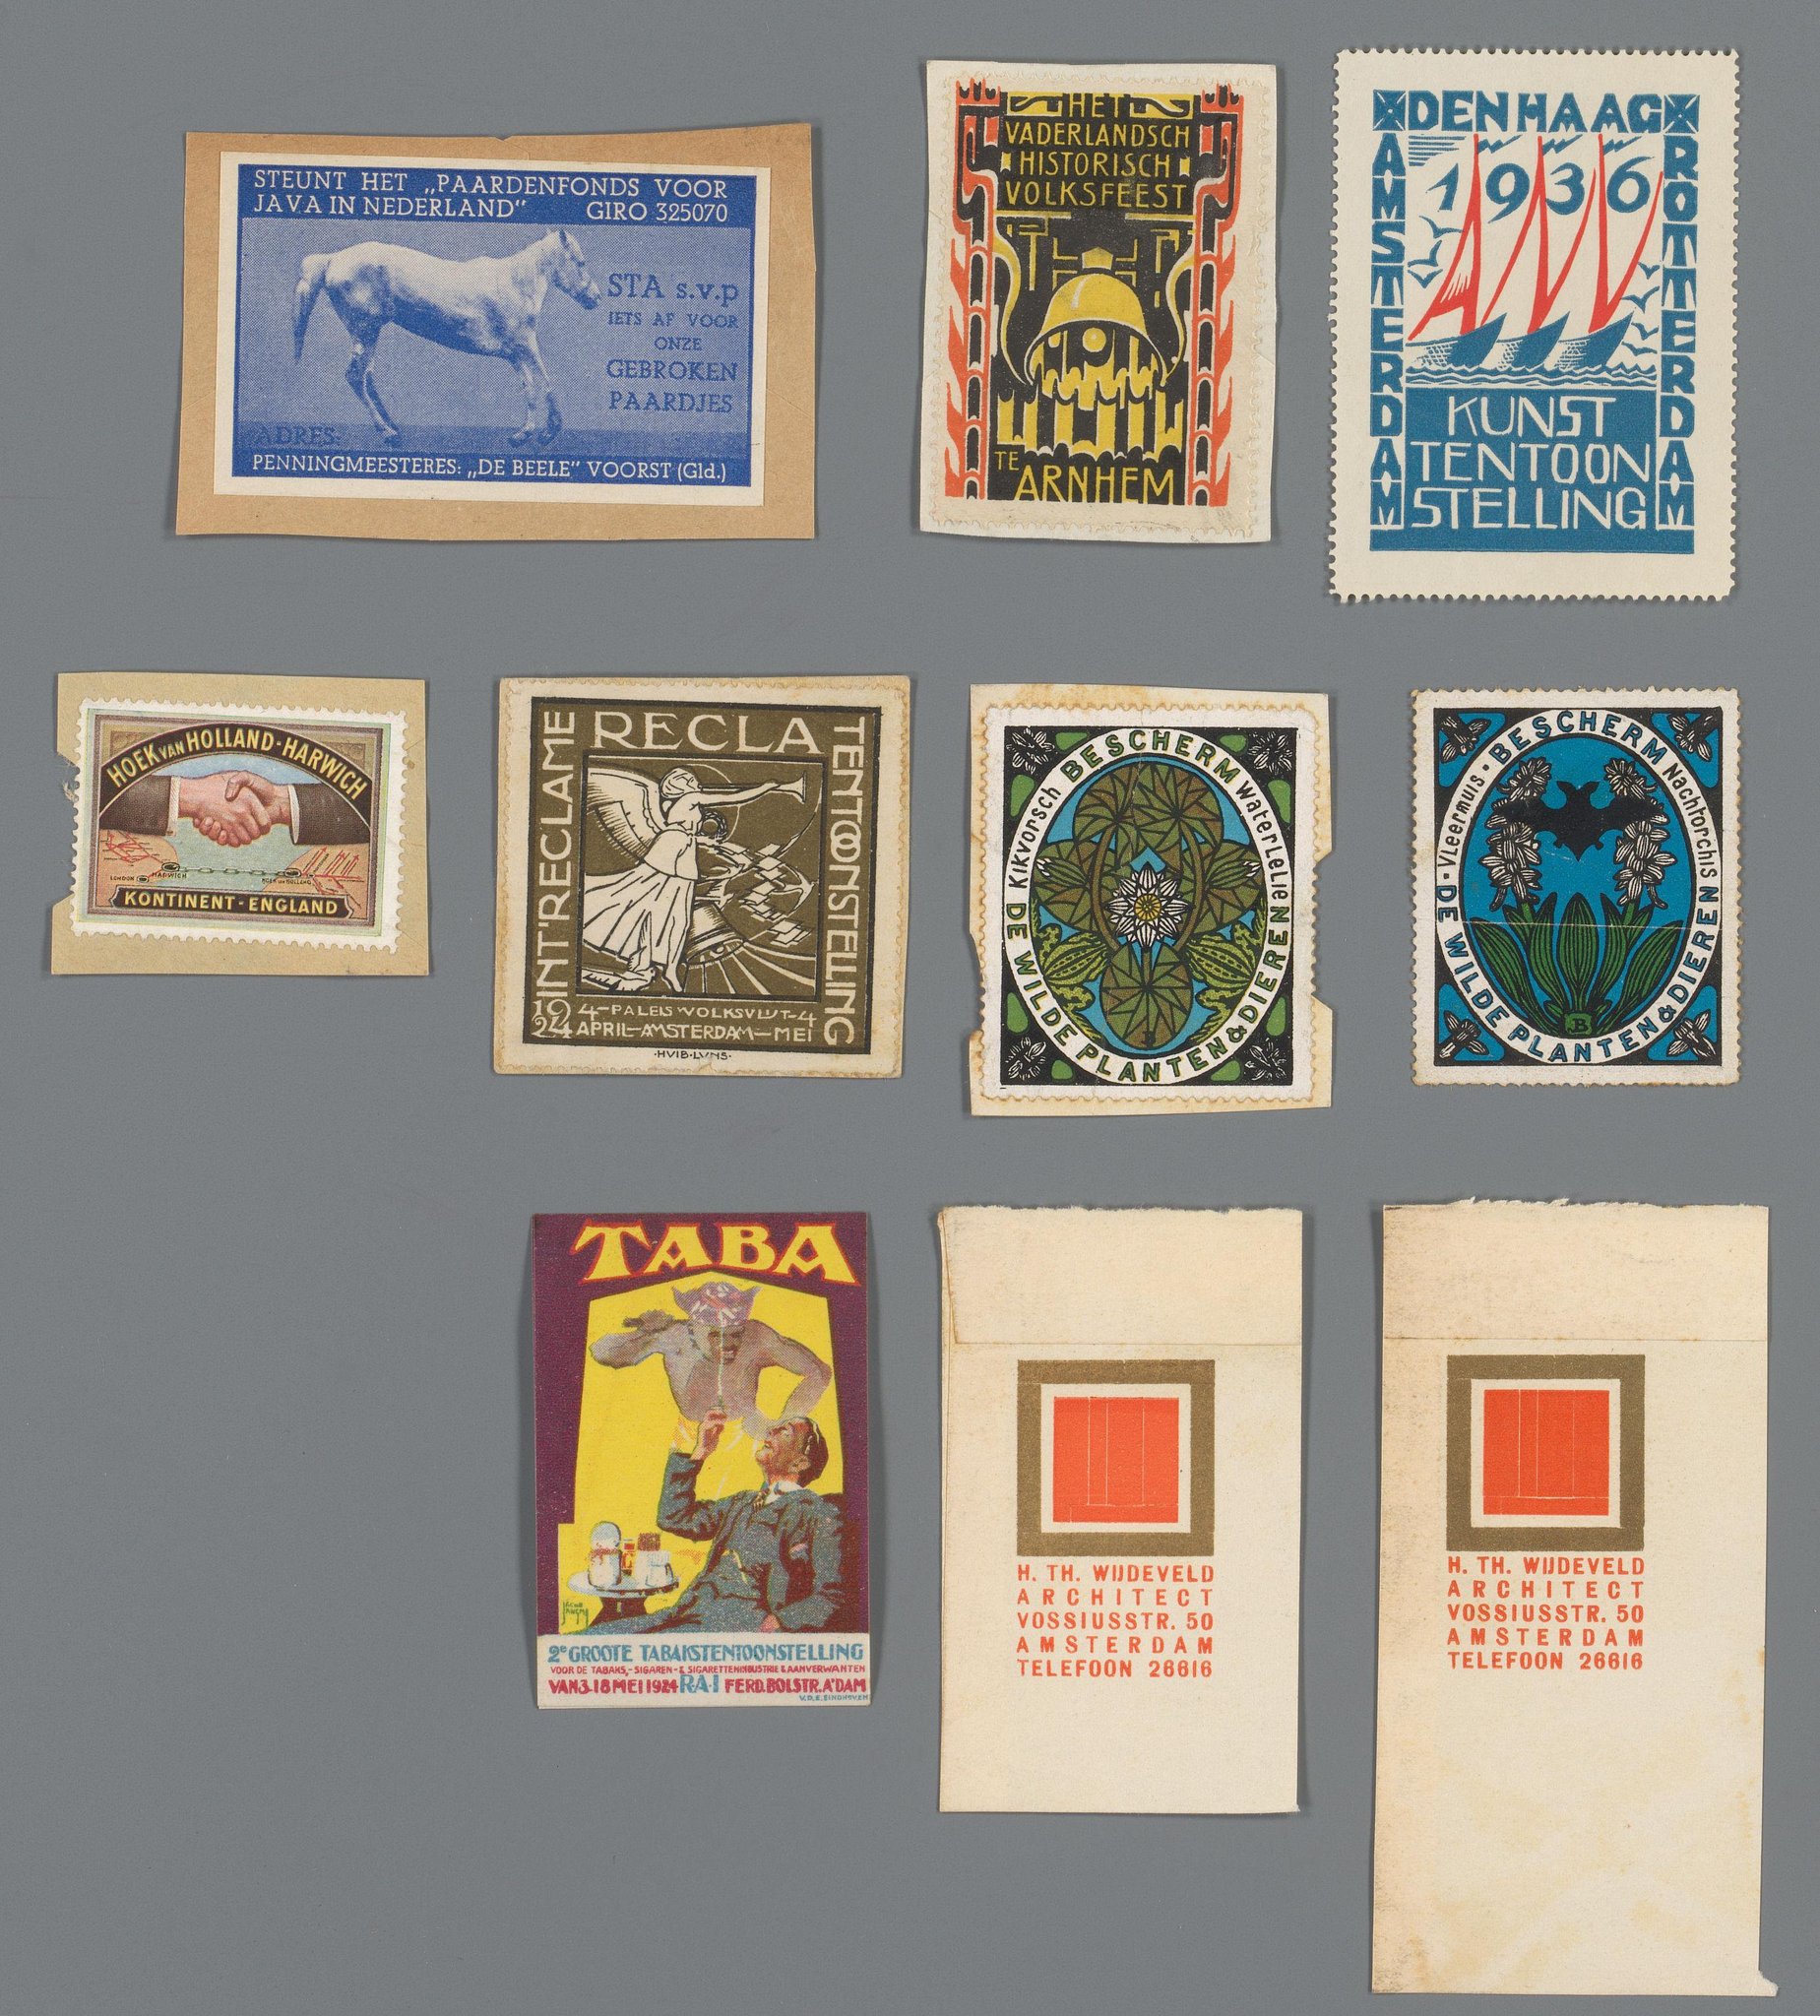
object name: vignette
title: Tien sluitzegels en vignetten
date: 1920-1950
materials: gum, paper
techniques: printing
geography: netherlands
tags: the hague, nijmegen, print maker, hendrikus theodorus wijdeveld, trade mark, trade token, trade sign, trade card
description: Groep van tien sluitzegels met reclame voor verschillende tentoonstellingen in Amsterdam, Rotterdam en Arnhem, goede doelen en commerciële bedrijven, plus twee vignetten voor de architect Hendrik Wijdeveld.